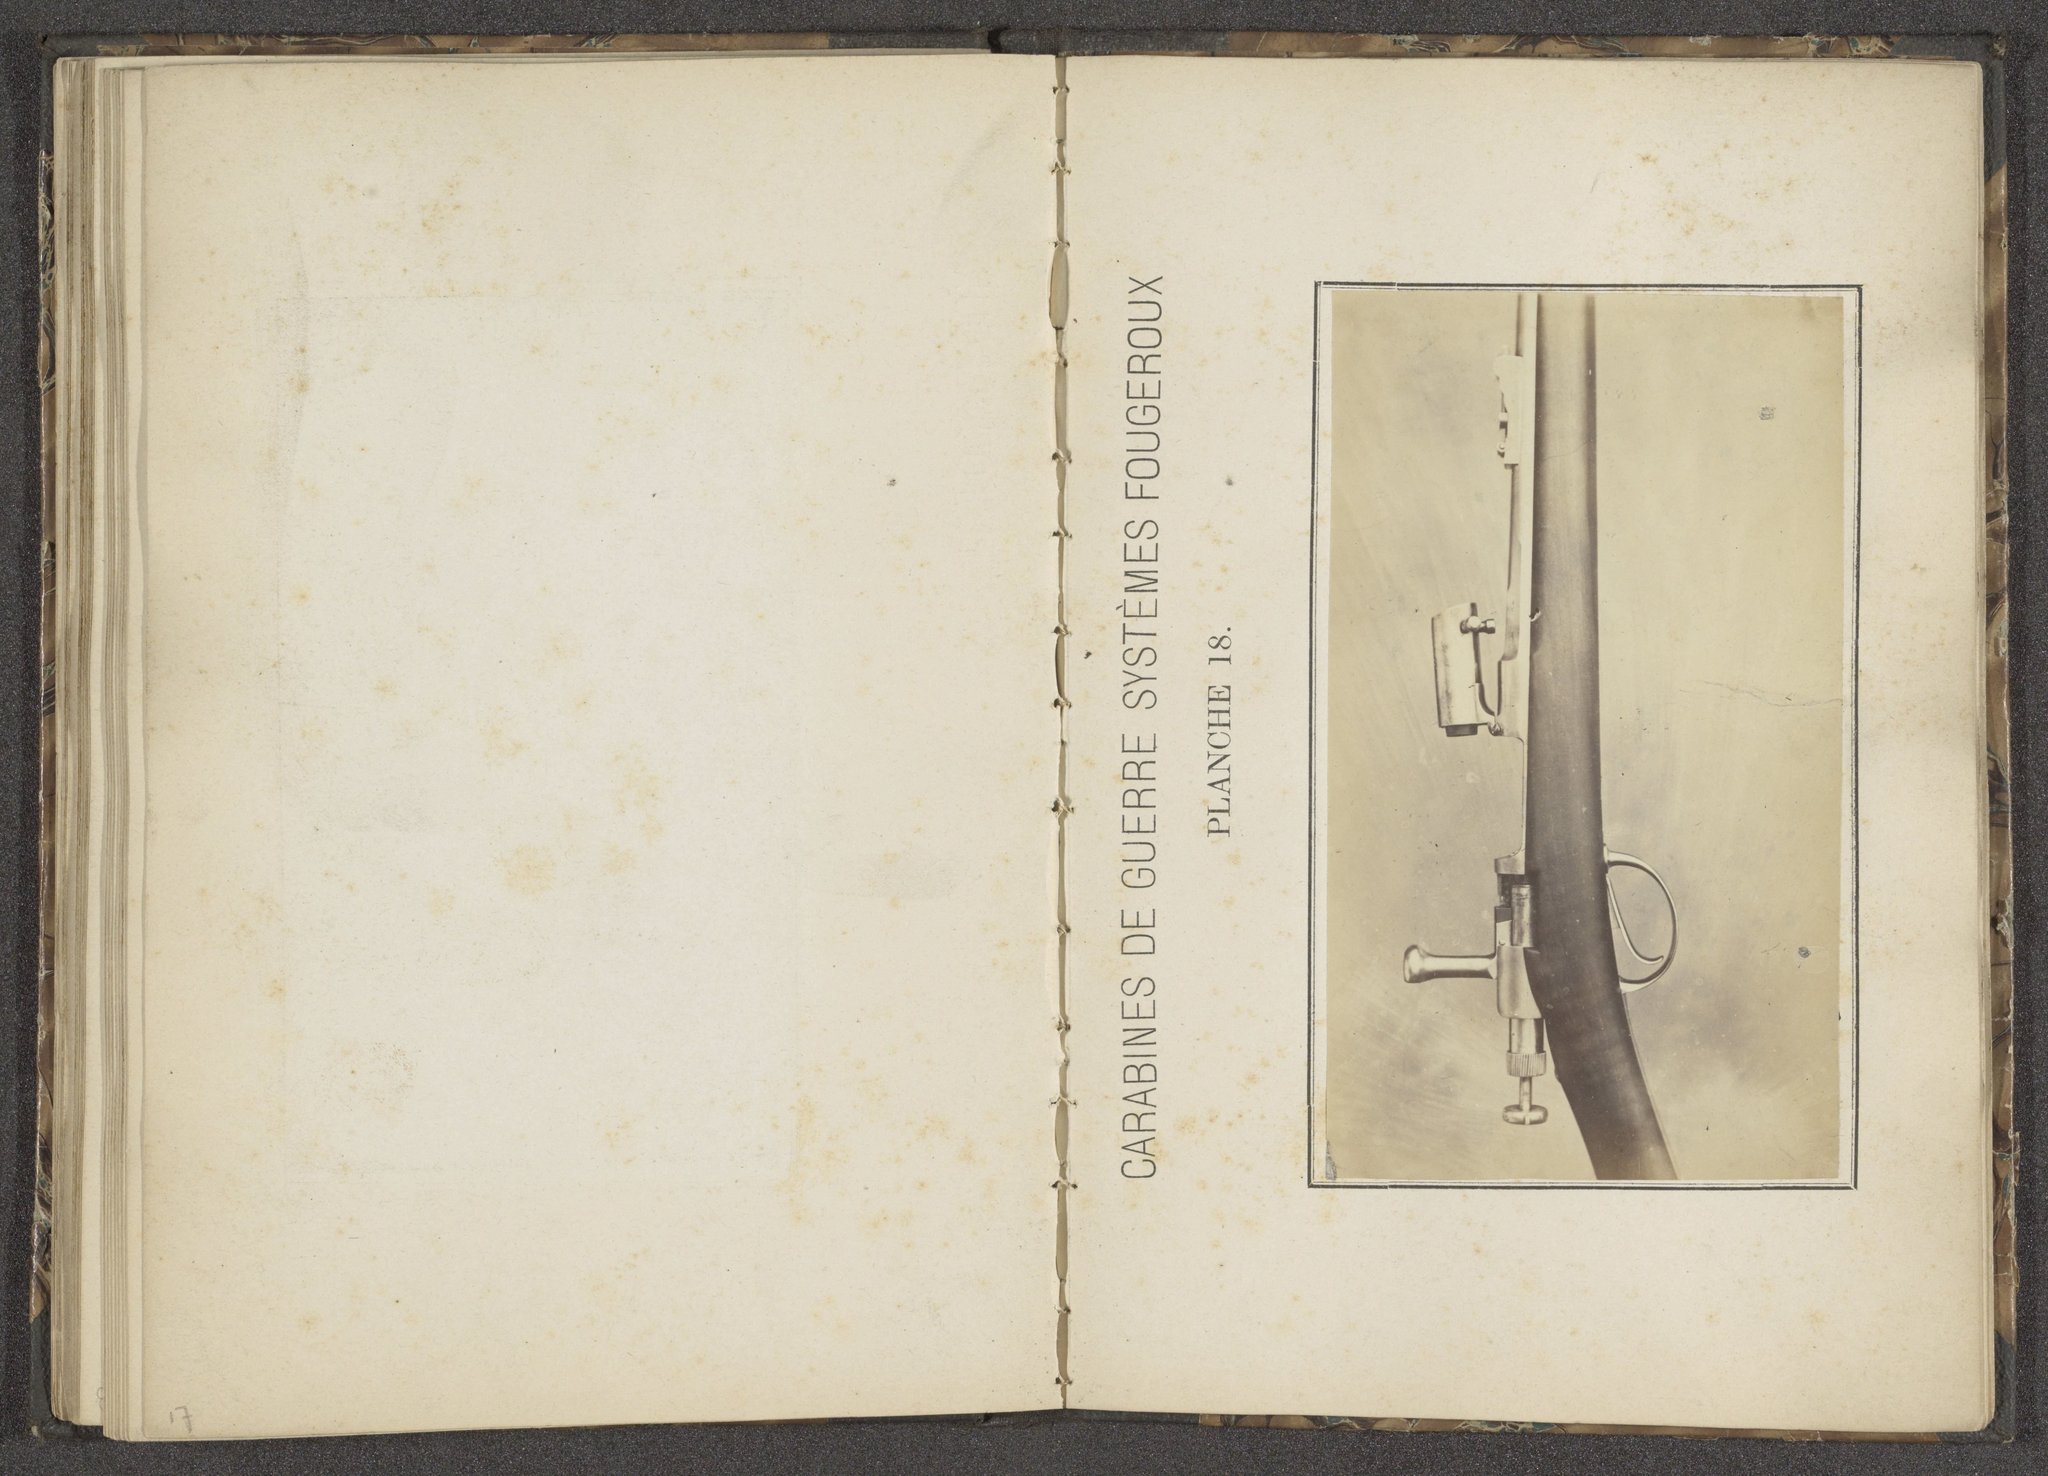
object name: photograph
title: Loop van een geweer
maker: edouard magis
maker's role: fotograaf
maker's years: 1828-1906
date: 1857-1867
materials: photographic support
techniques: albumen print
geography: liège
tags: firearms: rifle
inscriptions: inscription: ‘Carabines de guerres systèmes Fougeroux’, number: ‘Planche 18.’